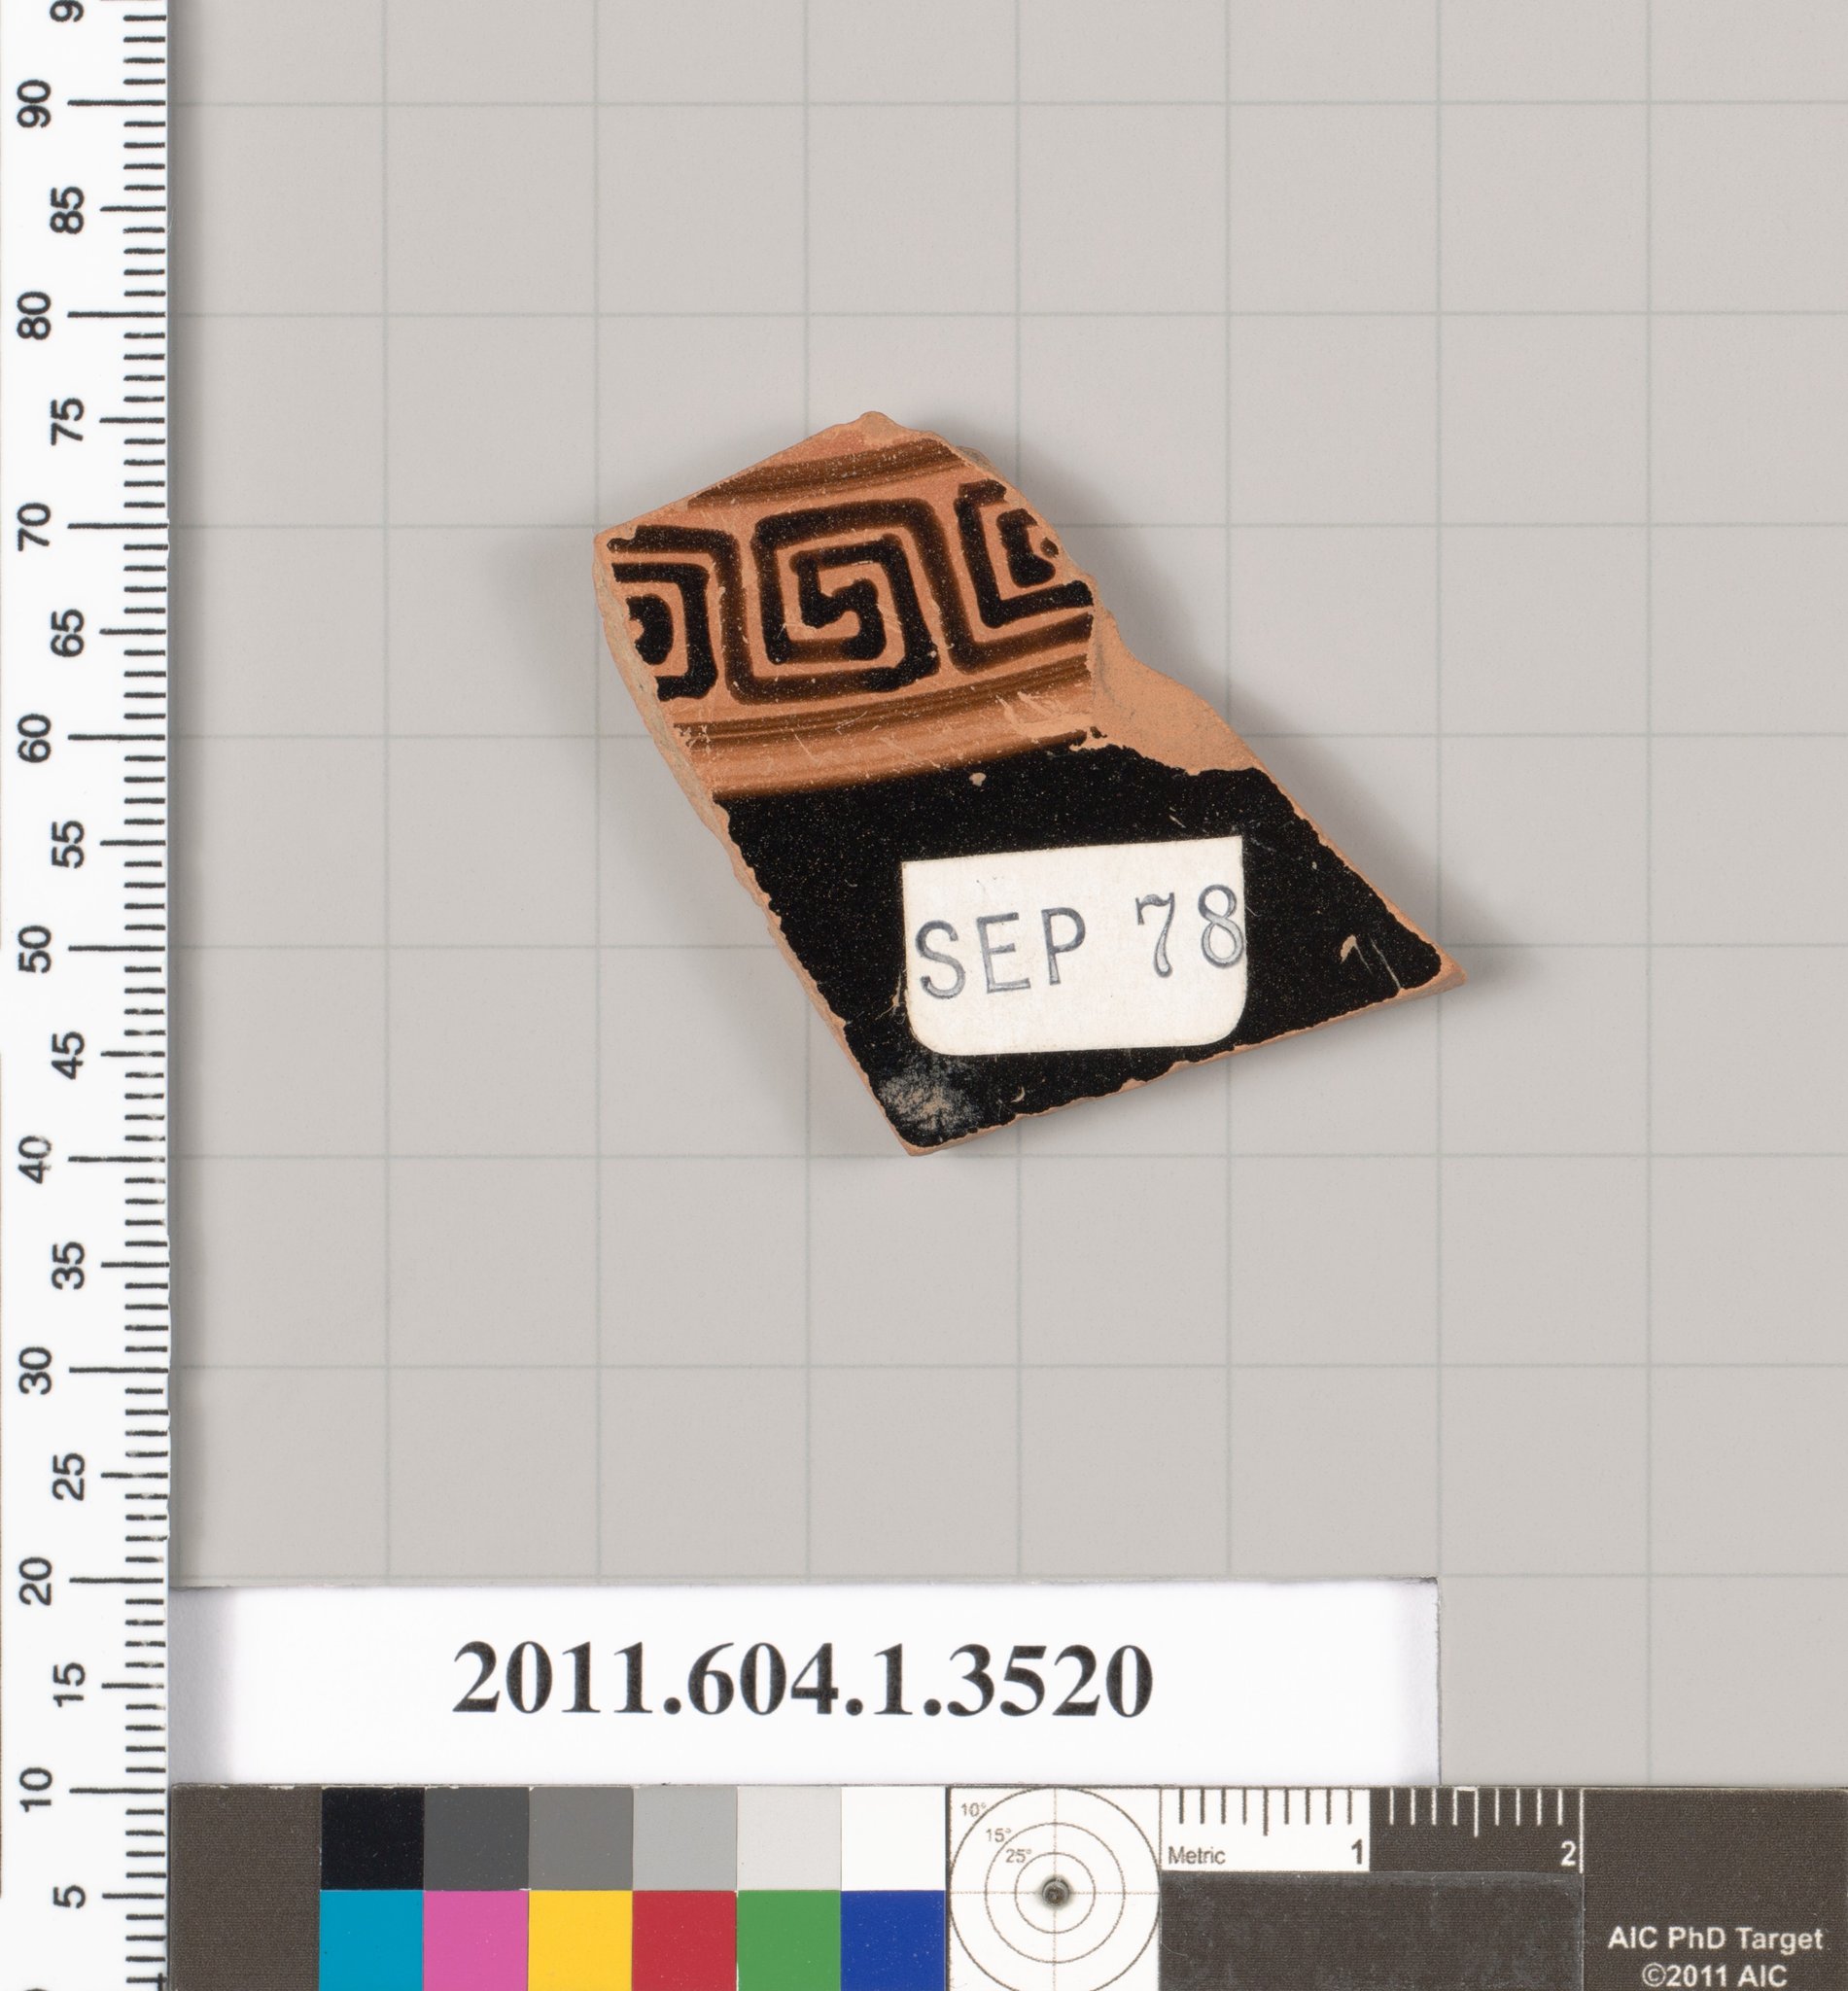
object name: kylix fragment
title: Terracotta fragment of a kylix (drinking cup)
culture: greek, attic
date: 475-451 BCE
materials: terracotta